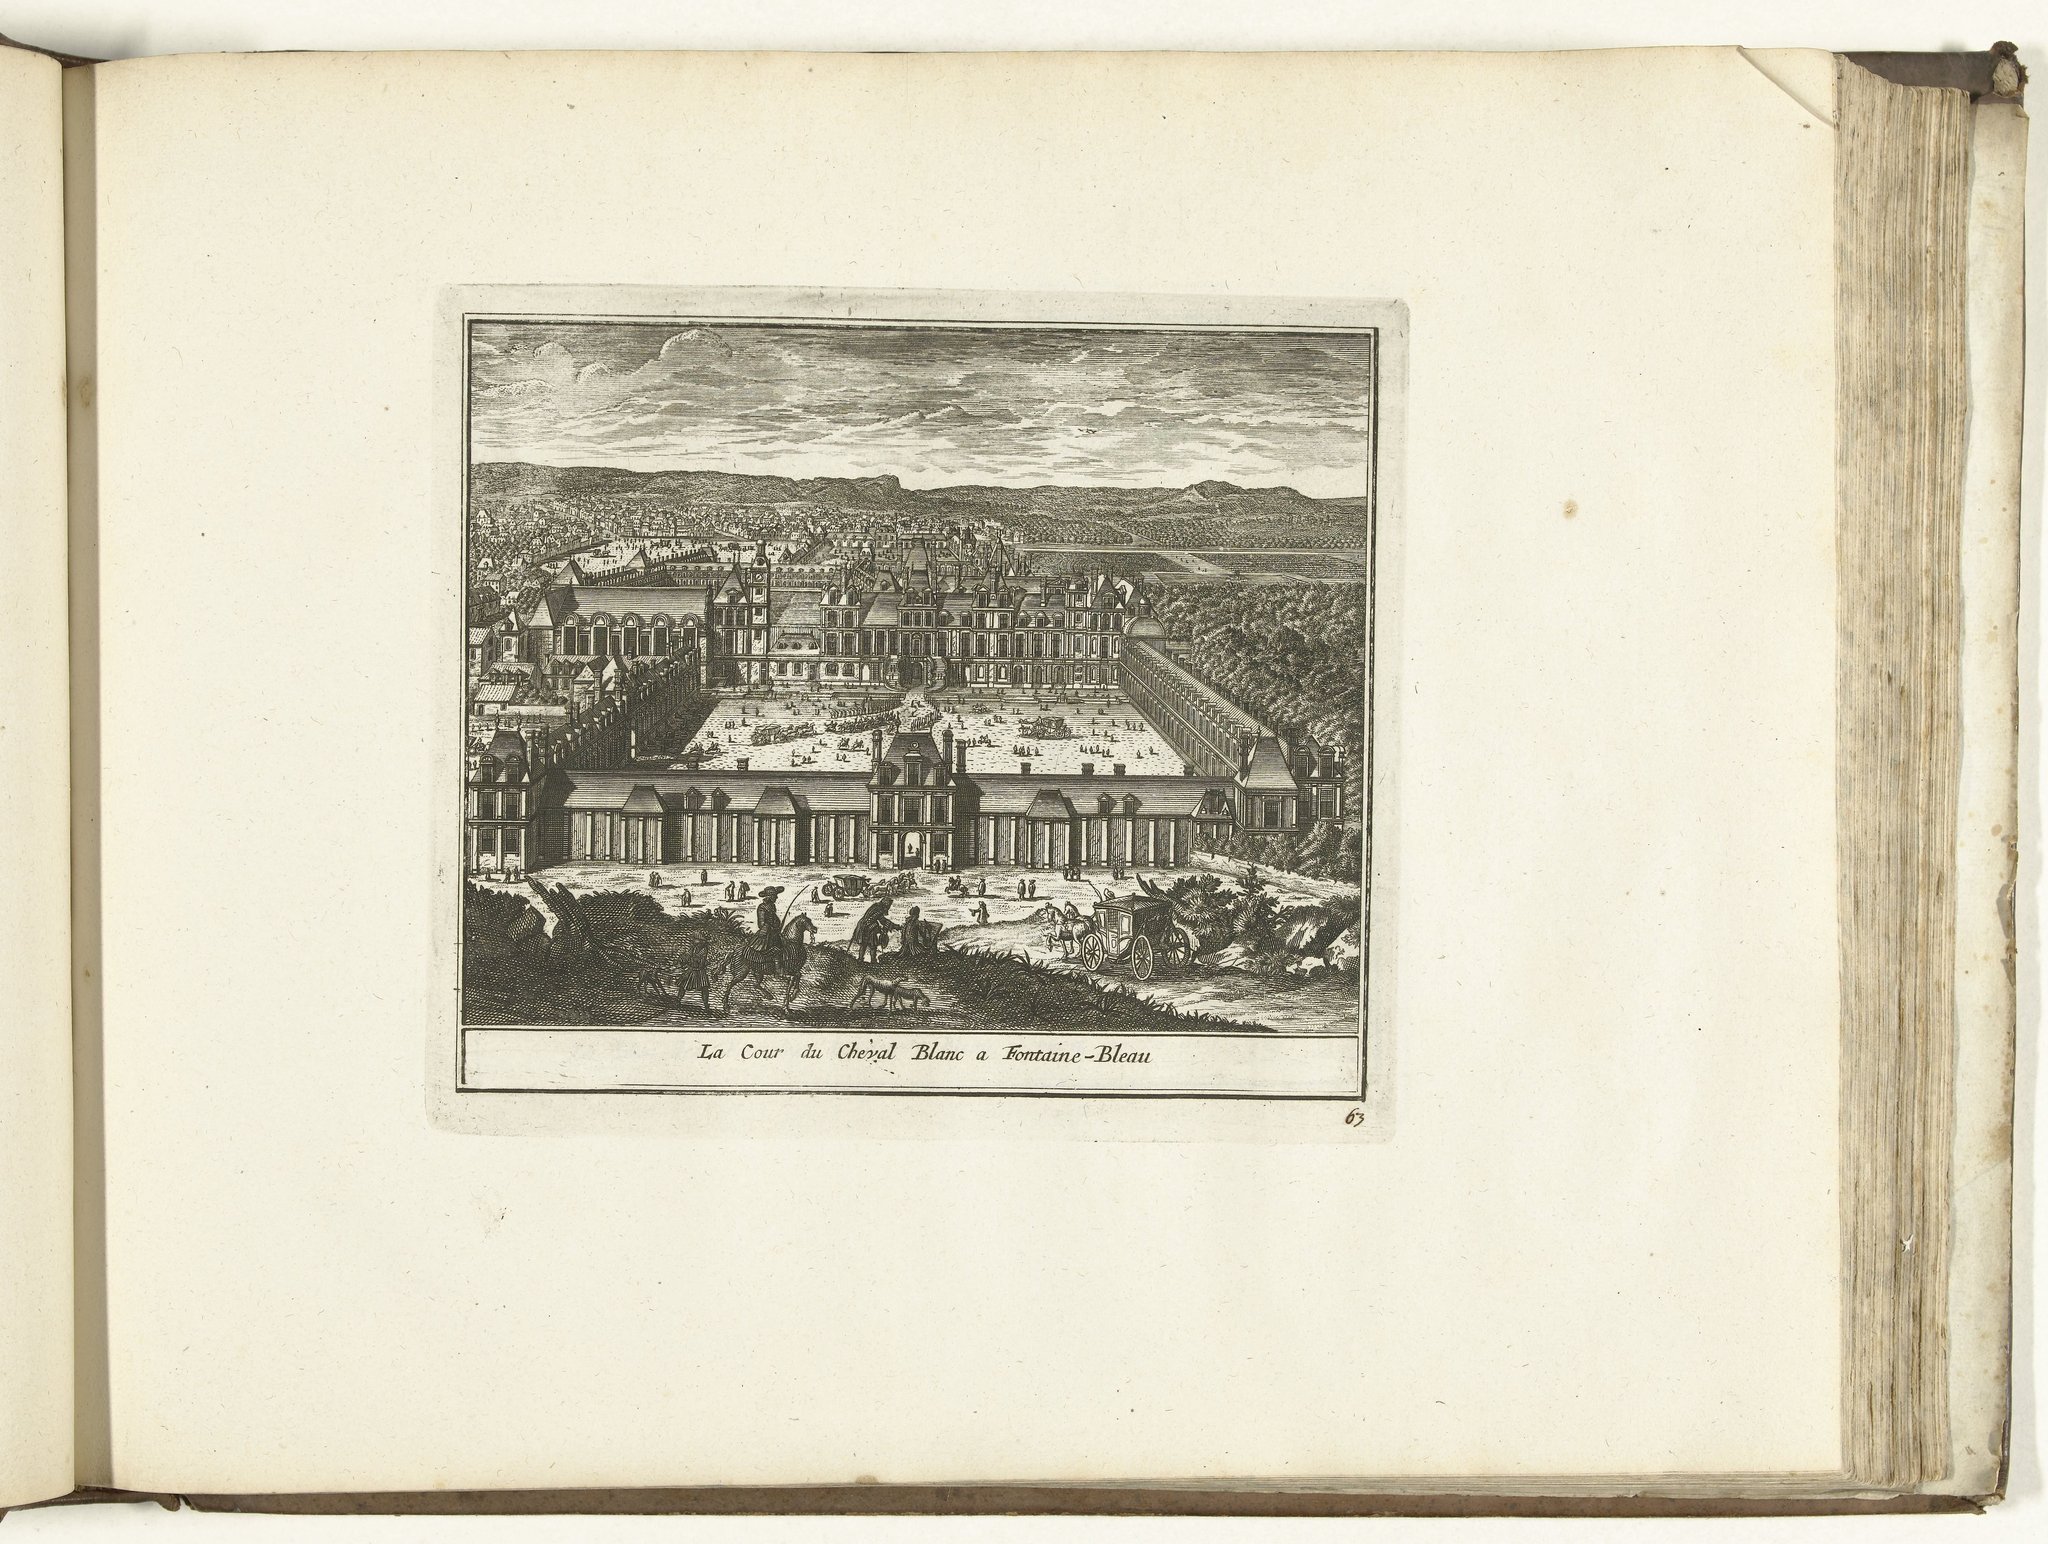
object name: print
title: Gezicht op de Cour du Cheval Blanc in het paleis van Fontainebleau, 1726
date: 1726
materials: paper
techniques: etching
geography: northern netherlands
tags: palace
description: Gezicht op de Cour du Cheval Blanc in het paleis van Fontainebleau. Plaat nr. 63 in deel III van het prentwerk: Les Forces de l'Europe, Asie, Afrique et Amerique ... Comme aussi les Cartes des Côtes de France et d'Espagne uit 1726, dit eerste deel met 238 met de hand genummerde platen van vermaarde sterke steden en vestingen in het kader van de Spaanse Successieoorlog 1701-1713. Voor het merendeel zijn deze platen gekopieerd naar de anonieme Franse platen van vermaarde sterke steden en vestingen: in Les forces de l'Europe en in: Le theatre de la guerre, dans les Pays-Bas, beide oorspronkelijk uitgegeven door Nicolas de Fer te Parijs (1693-1697) in het kader van de Negenjarige Oorlog. Titel in het Frans.